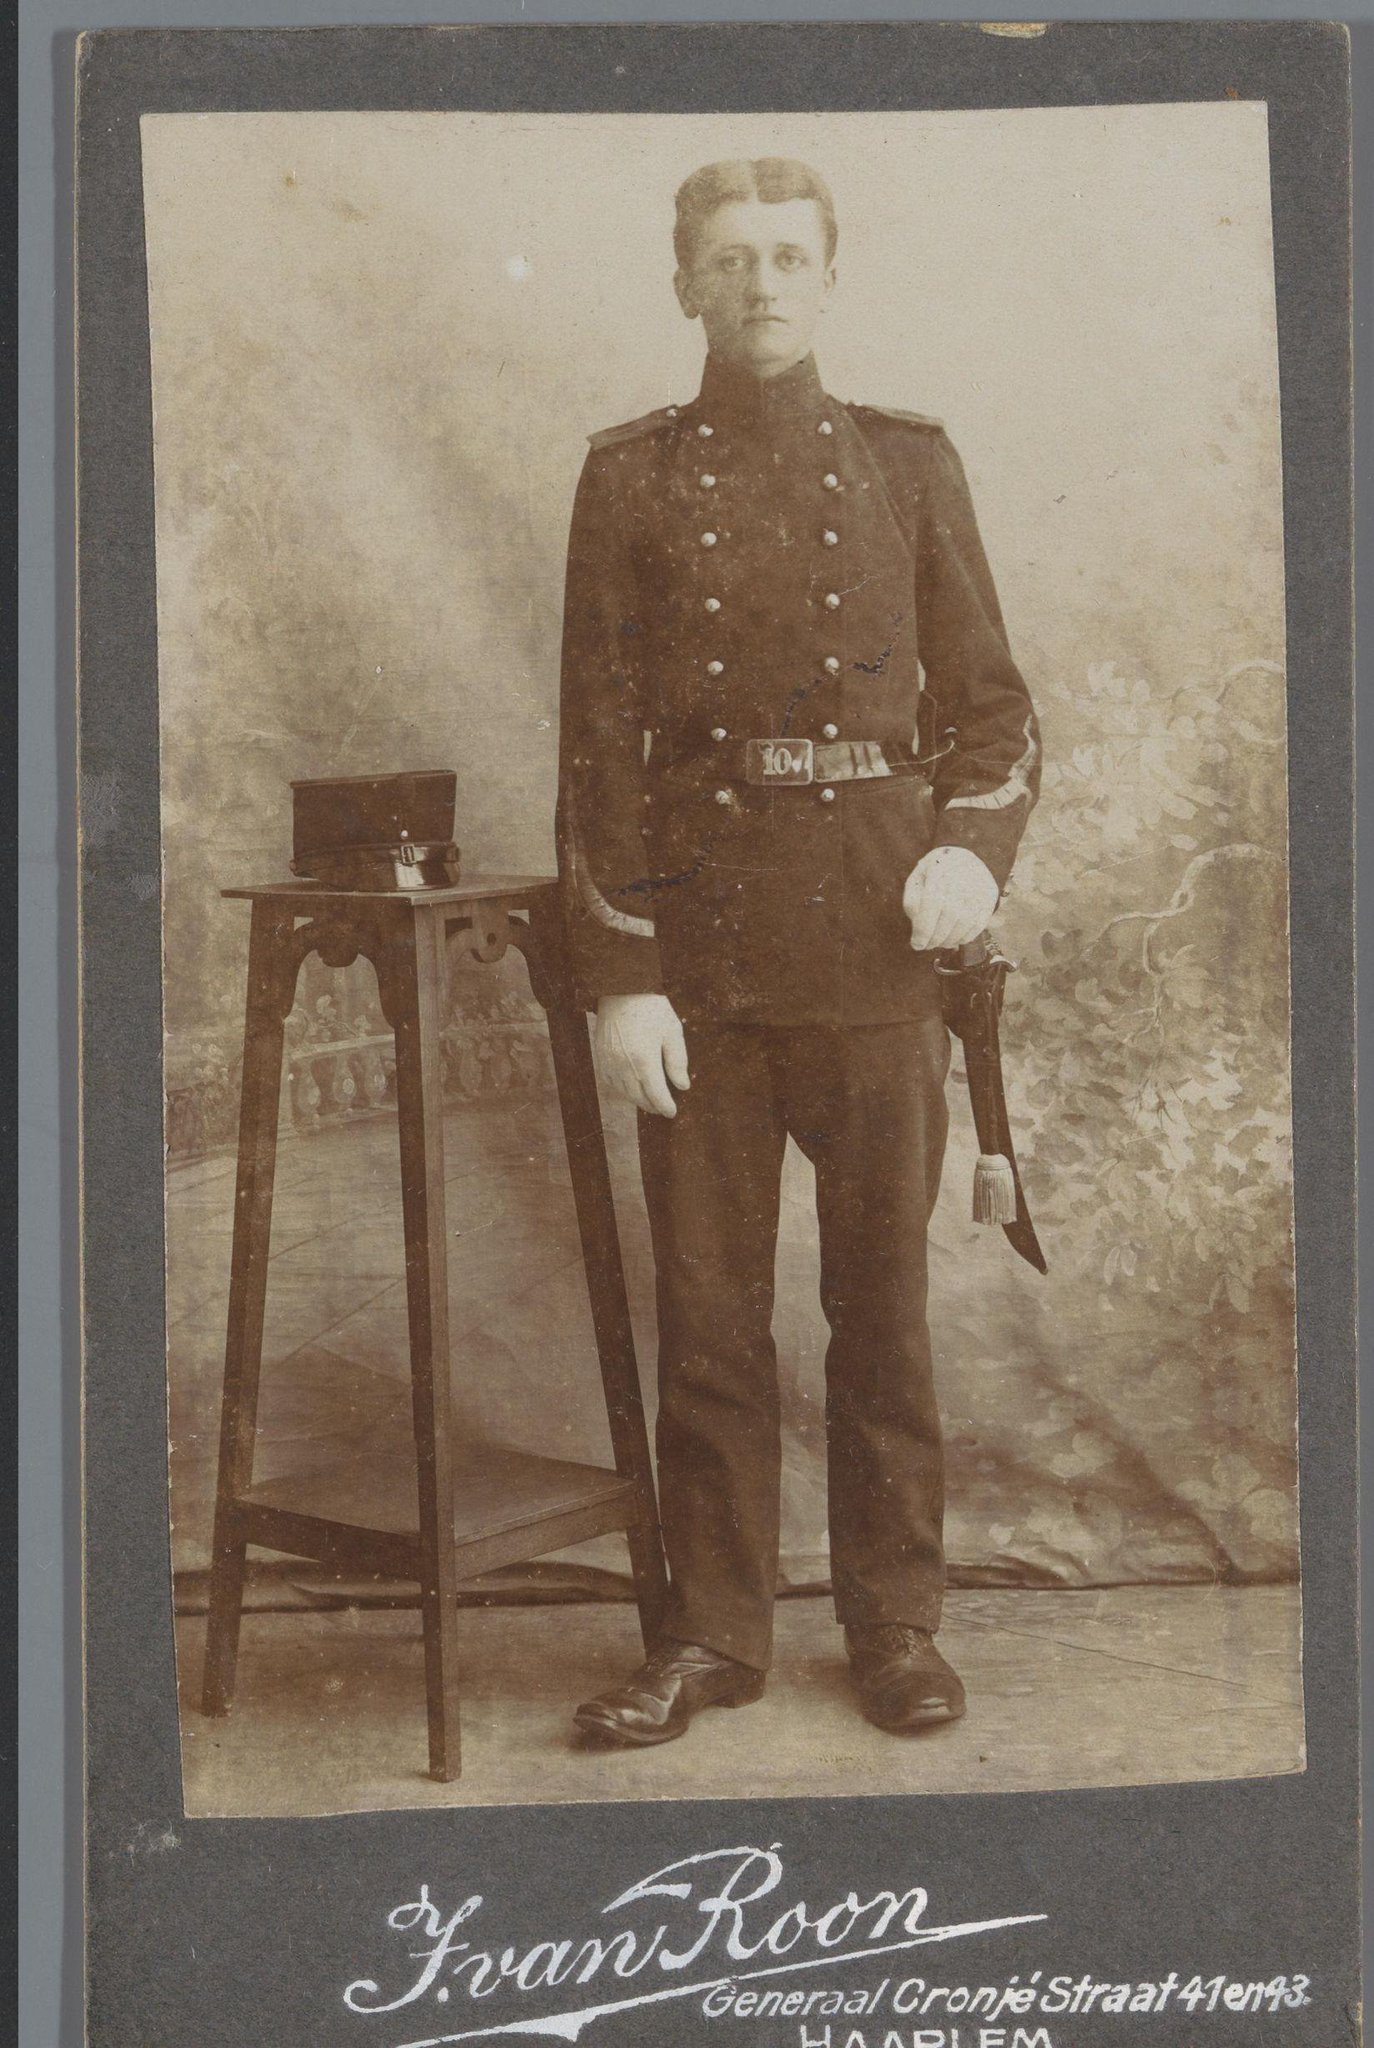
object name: carte de visite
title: Portret van een onbekende jongeman in uniform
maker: jan van roon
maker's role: fotograaf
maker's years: 1879-1948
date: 1903-1920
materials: paper, cardboard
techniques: collodion silver print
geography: haarlem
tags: youth, adolescent, anonymous historical person portrayed, (military) uniforms, haarlem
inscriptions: inscription: ‘J. van Roon/ Generaal Cronjéstraat 41 en 43./ Haarlem.’